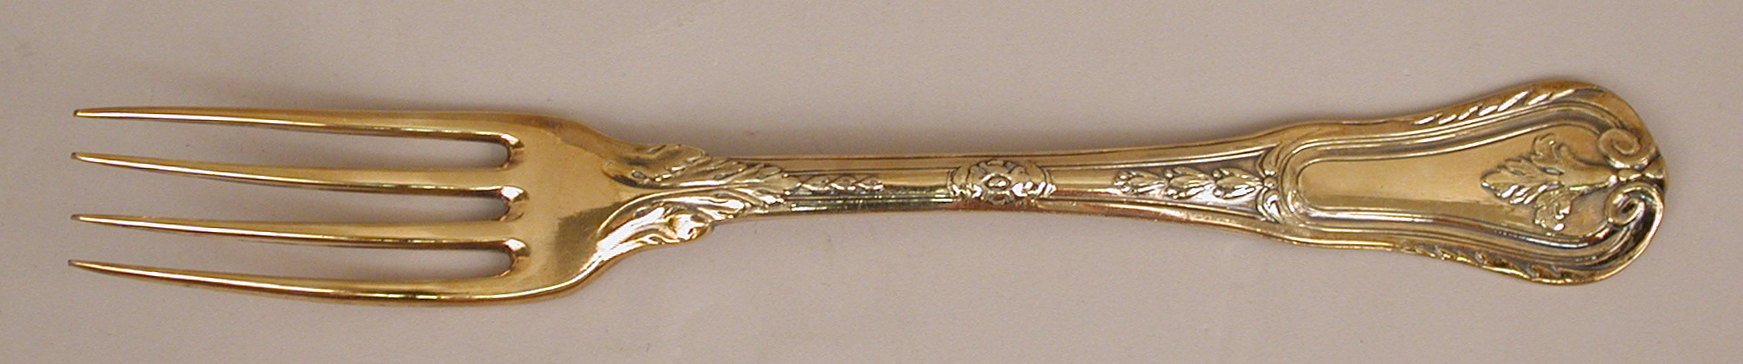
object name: fork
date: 1783-1789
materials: silver gilt